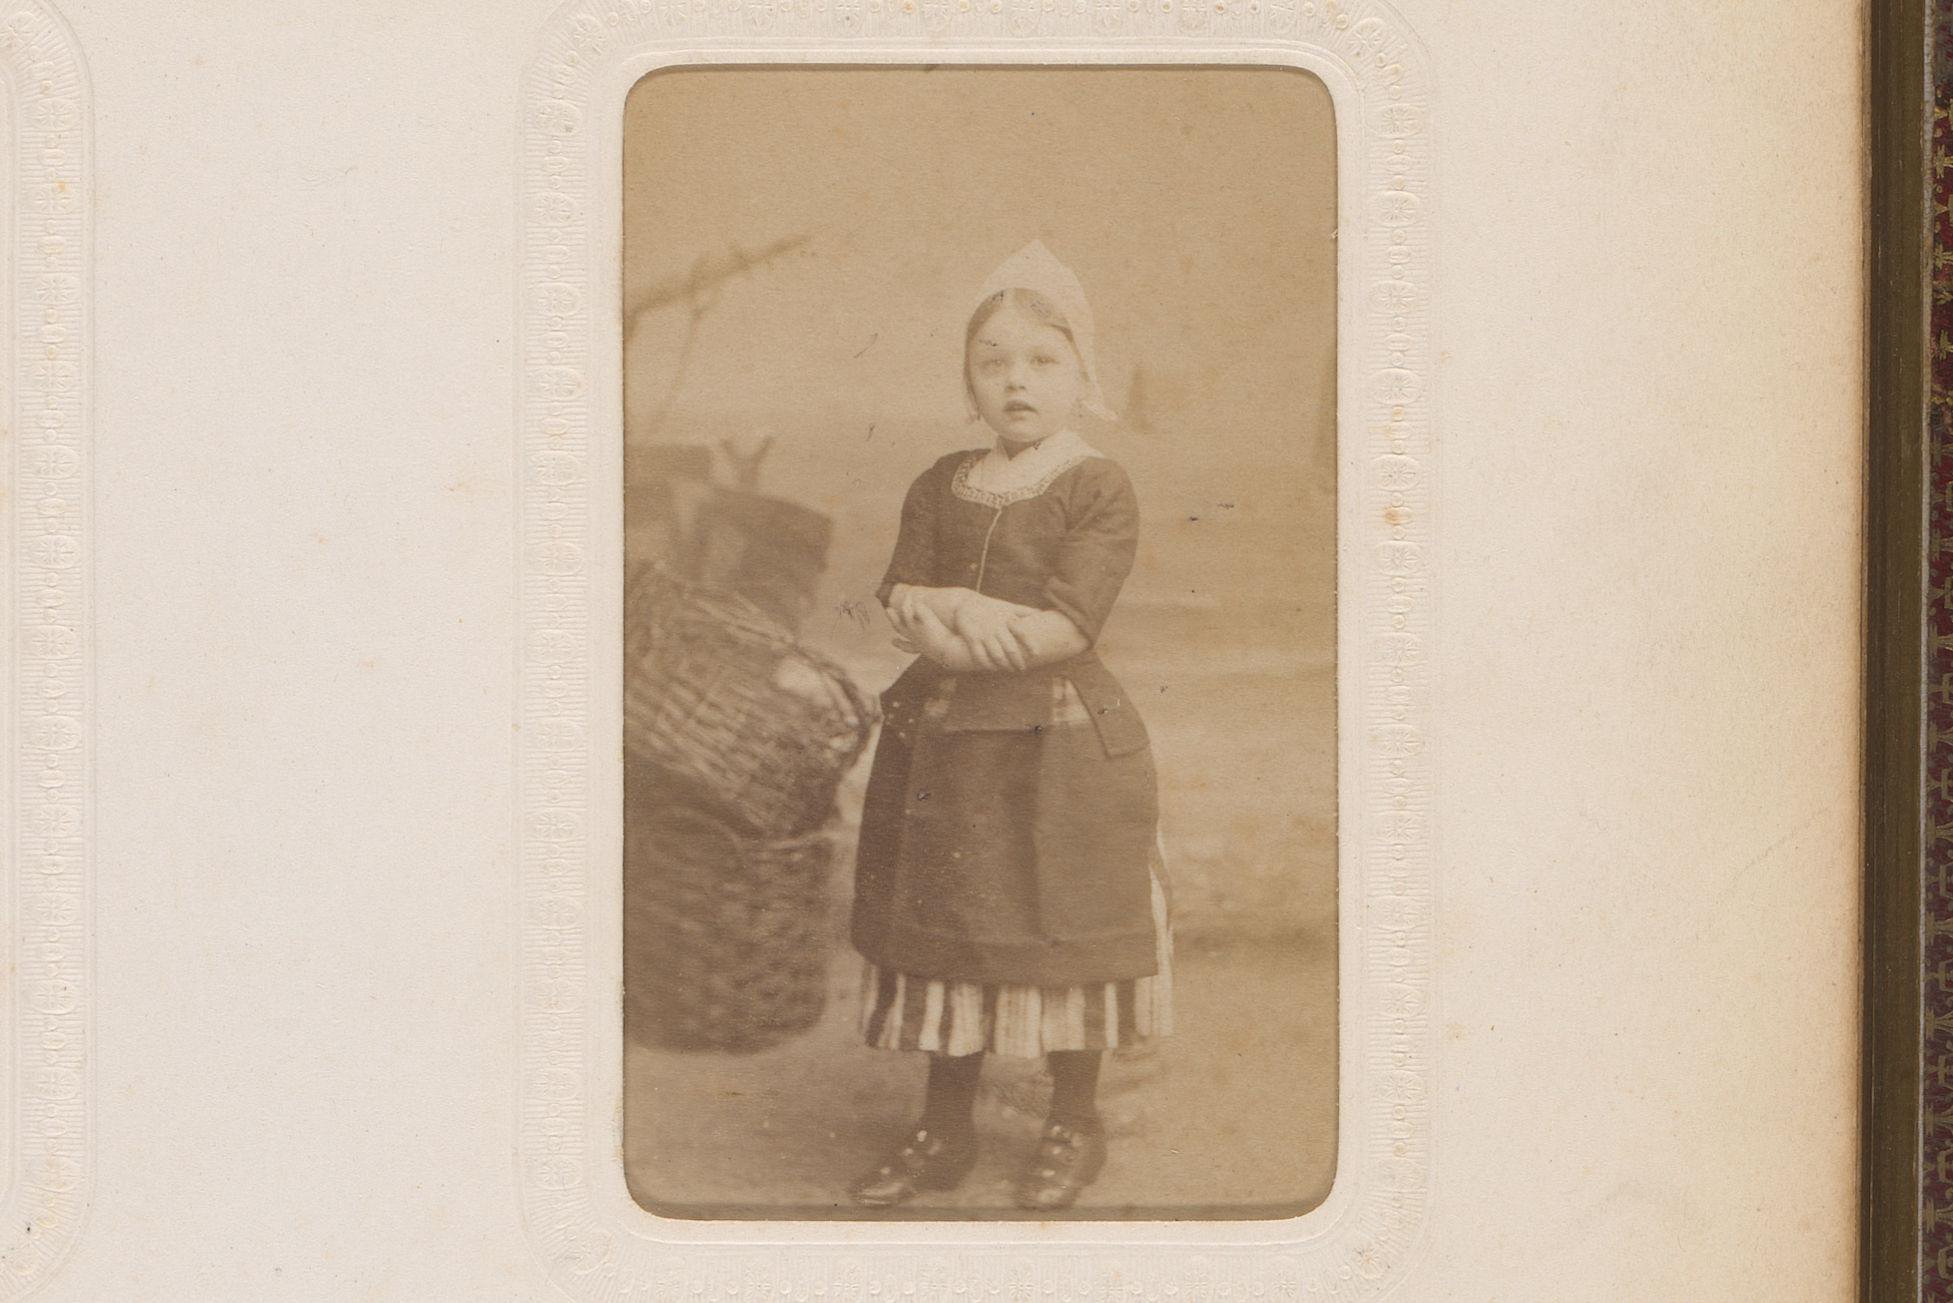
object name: album leaf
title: Portret van een zittend meisje met bal in de hand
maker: Anonymous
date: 1860-1900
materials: cardboard, photographic support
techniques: albumen print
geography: netherlands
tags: sitting figure - aa - female human figure, historical persons - bb - woman, girl (child between toddler and youth)